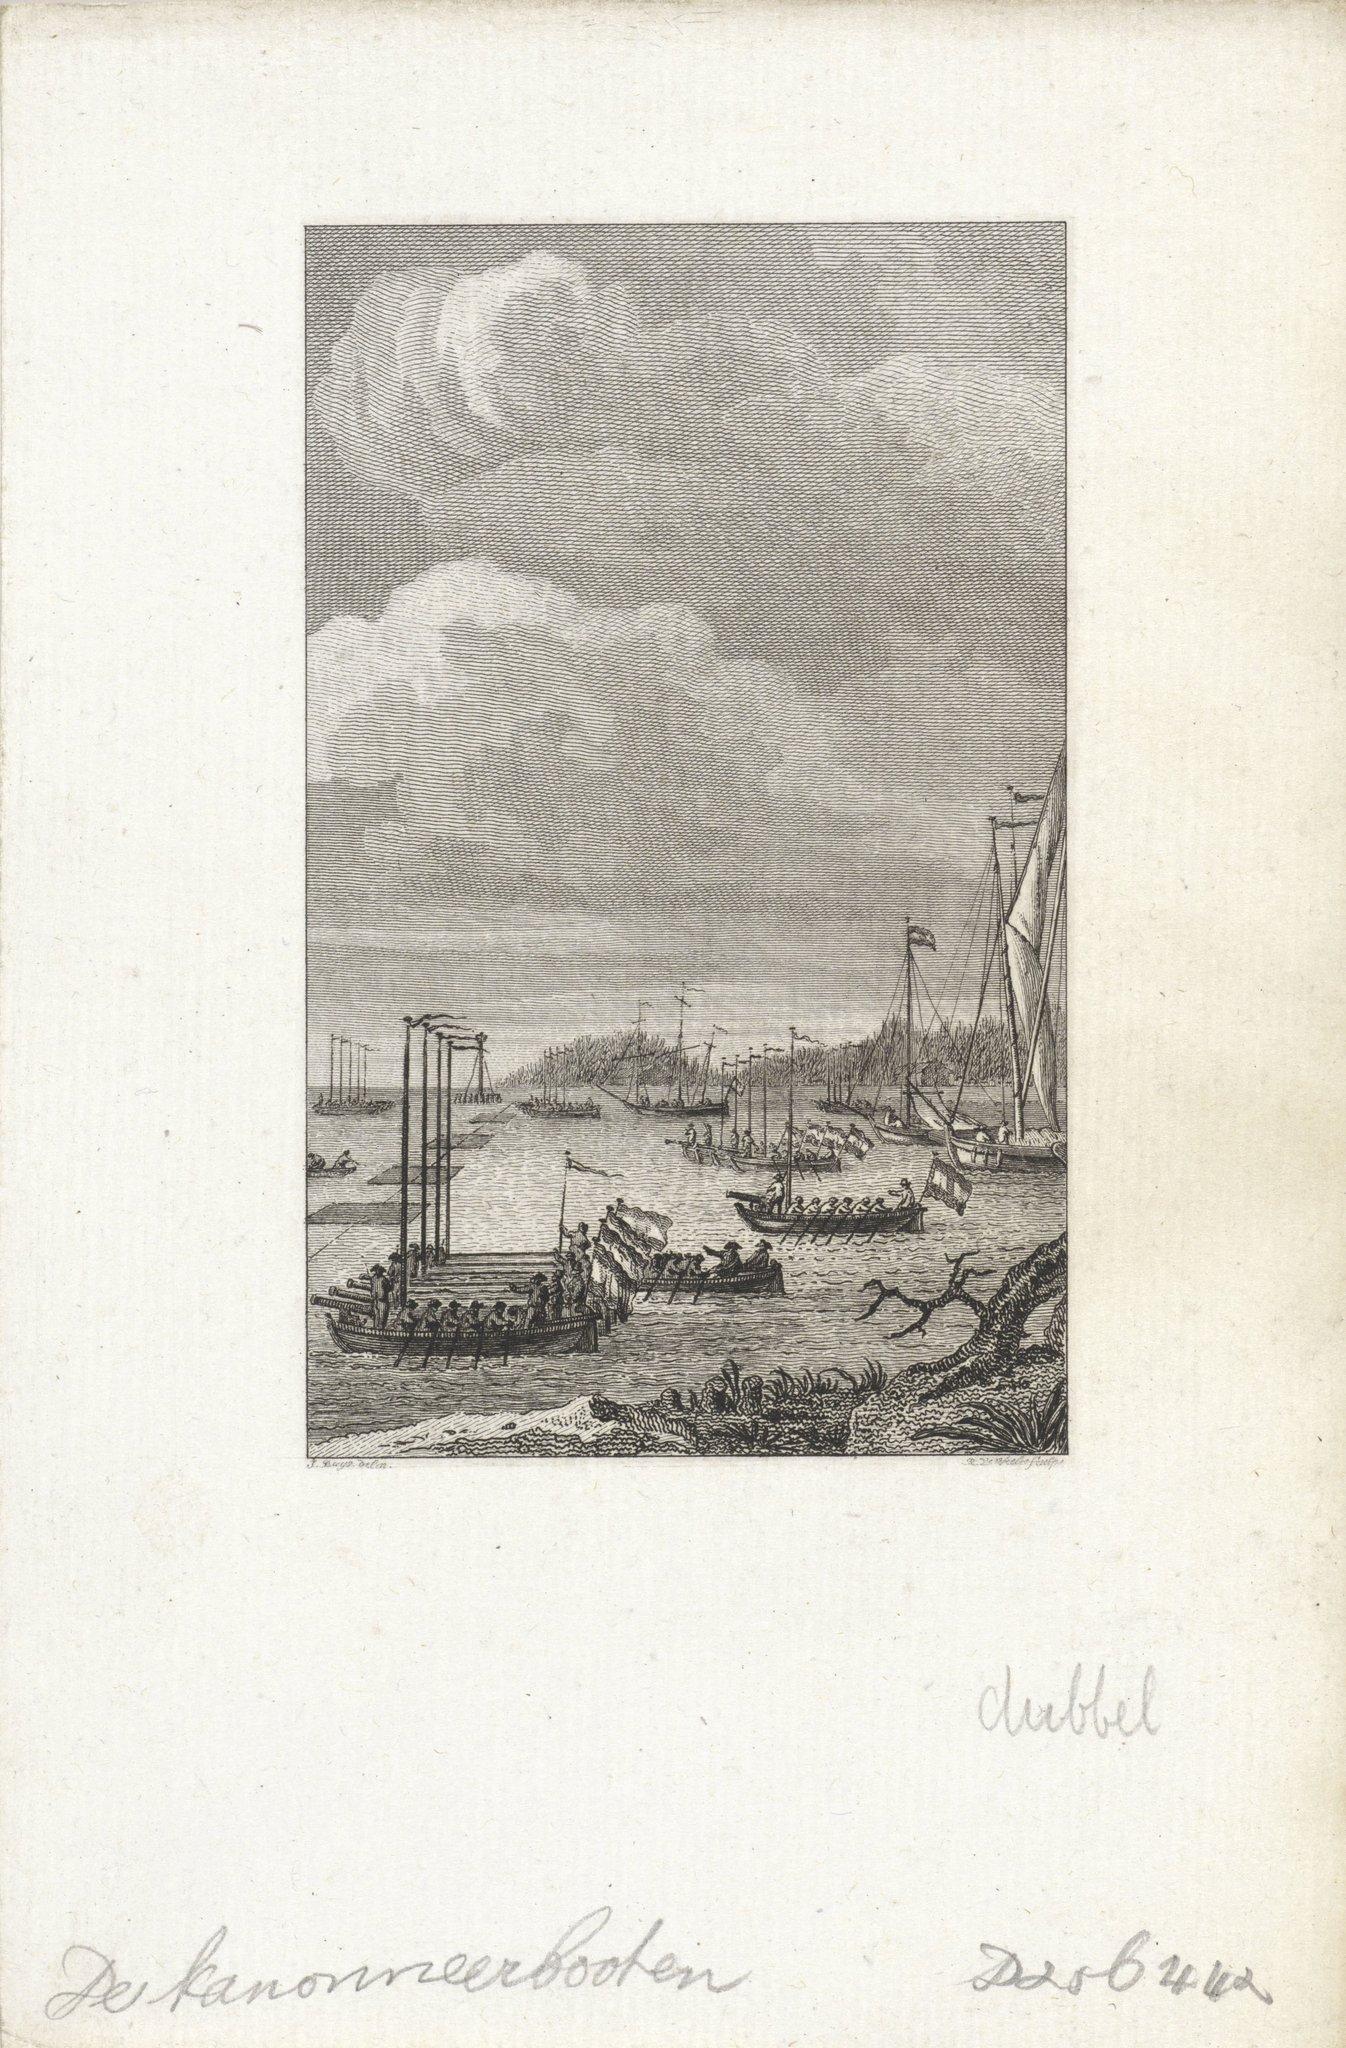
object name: history print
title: Kanonneersloepen in de Dordtsche Kil, 1793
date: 1800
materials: paper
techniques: engraving, etching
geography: amsterdam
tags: chains across waterway, rowing-boat, canoe, etc.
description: Gebruikt als illustratie in: P.A. Loosjes. Vaderlandsche historie, vervattende de geschiedenissen, der Vereenigde Nederlanden (...). Ten onmiddelyken vervolge van Wagenaar's Vaderlandsche historie. Amsterdam: Johannes Allart, dl. 25 (1800), p. 442. Gekopieerd naar de prent van Bendorp naar Schouman, zie FMH 5208.